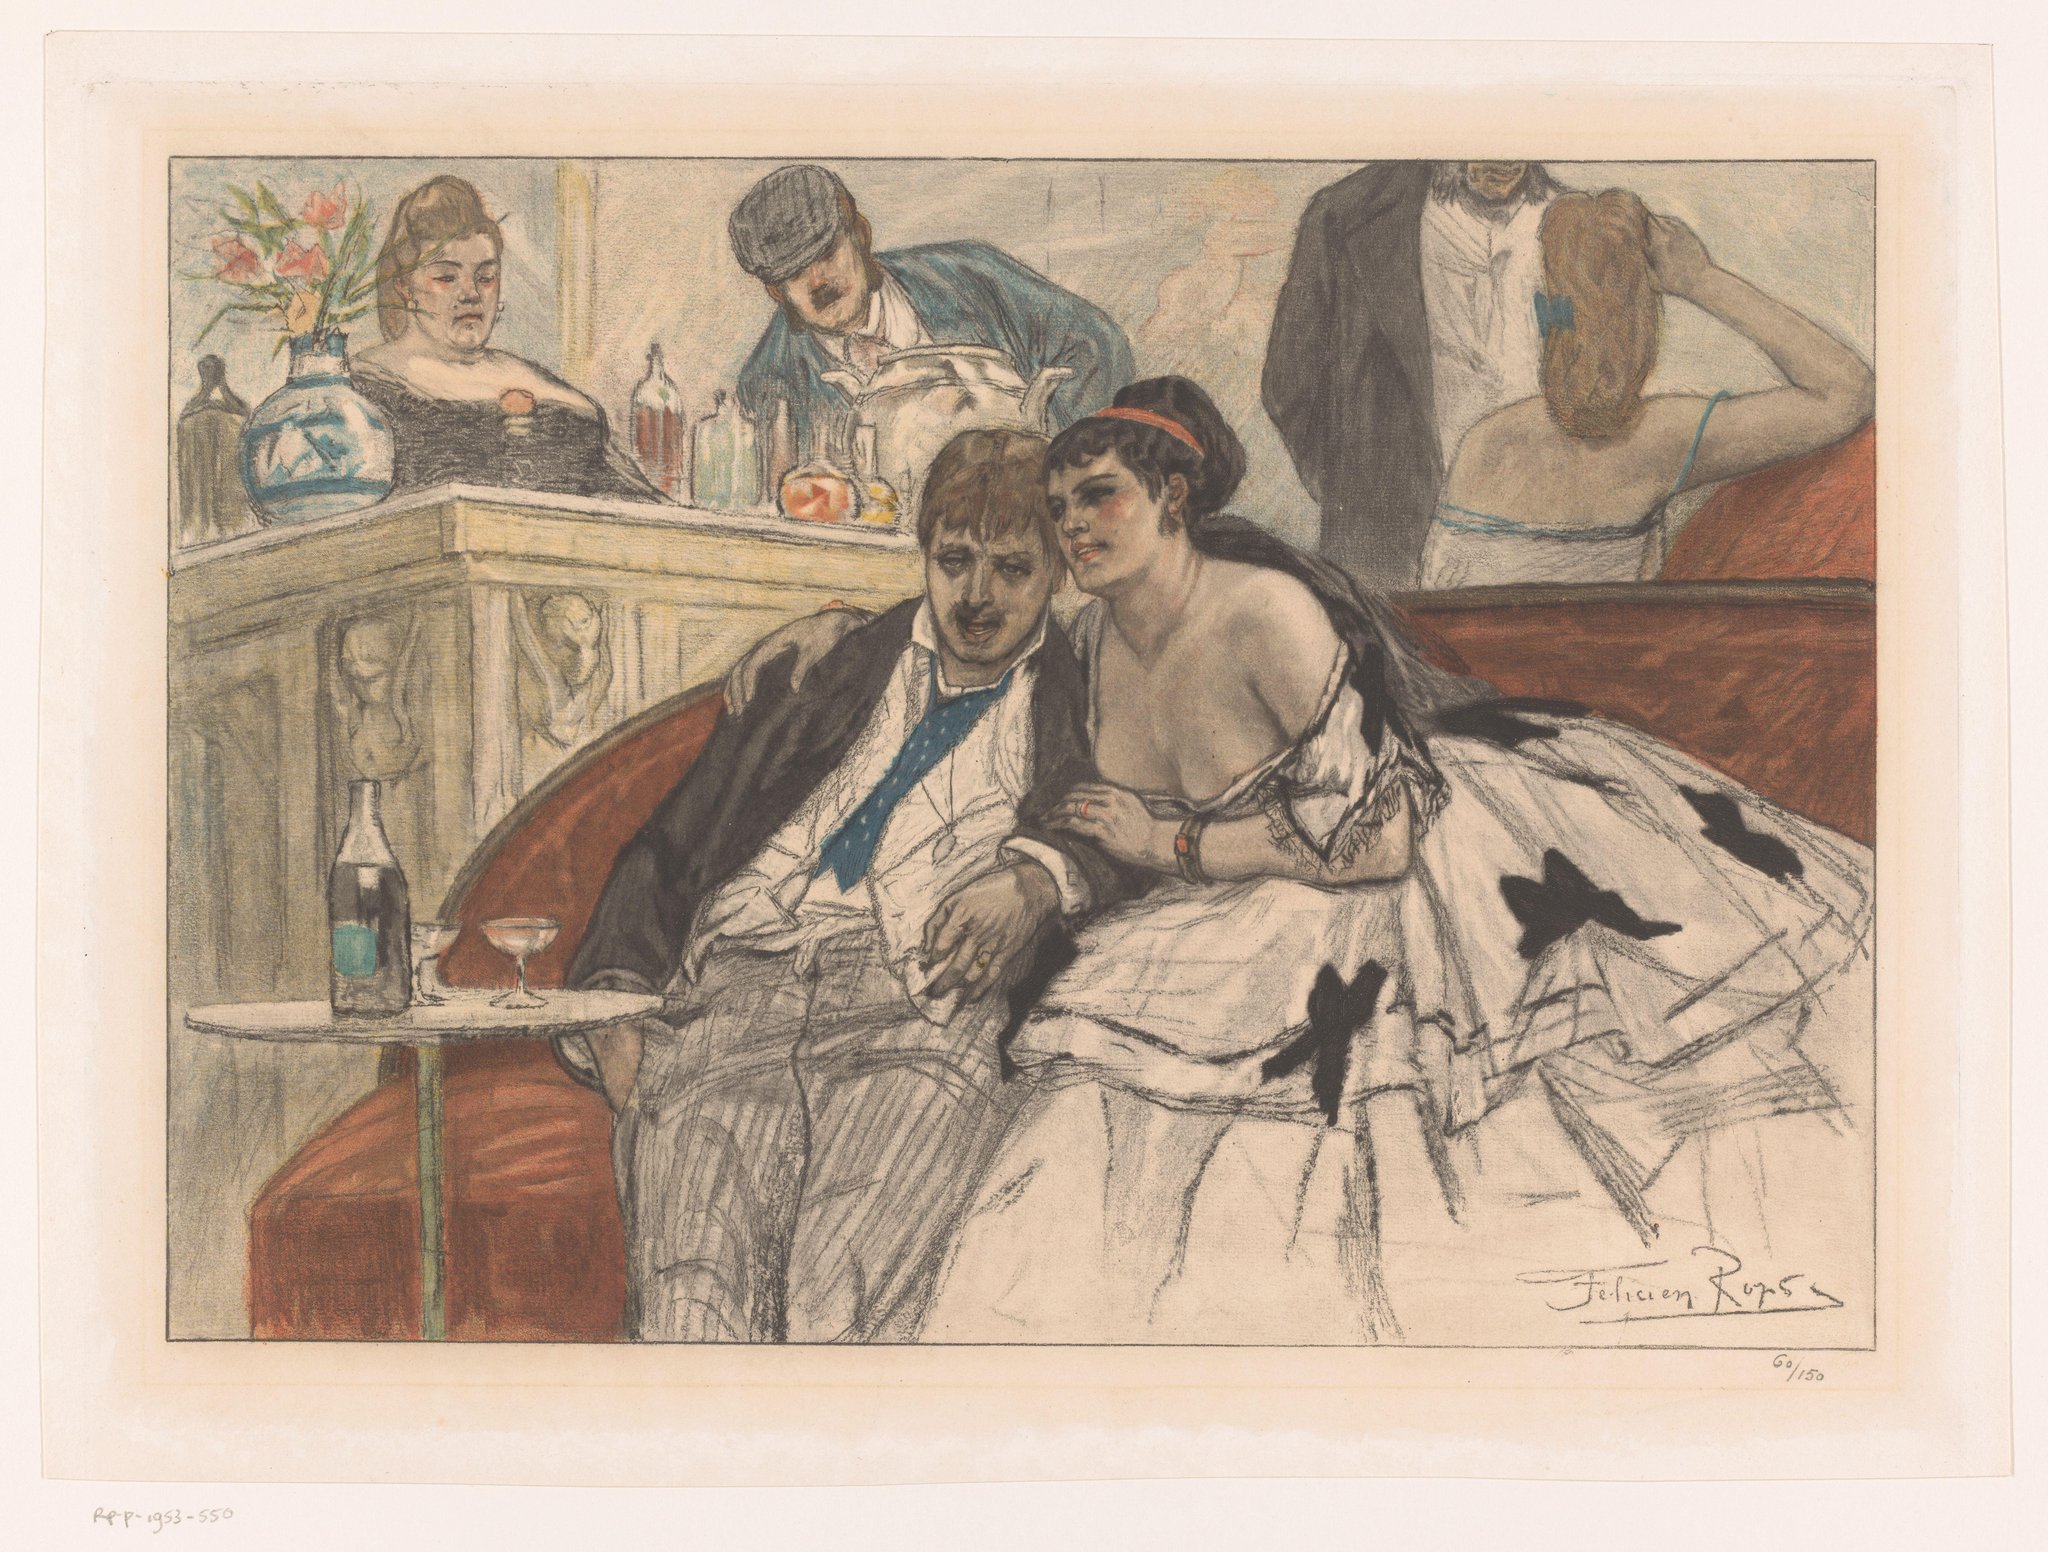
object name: print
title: Le gandin ivre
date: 1864-1912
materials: paper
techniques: soft ground etching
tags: theatre (building), couple of lovers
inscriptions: collector's mark: Lugt 2228